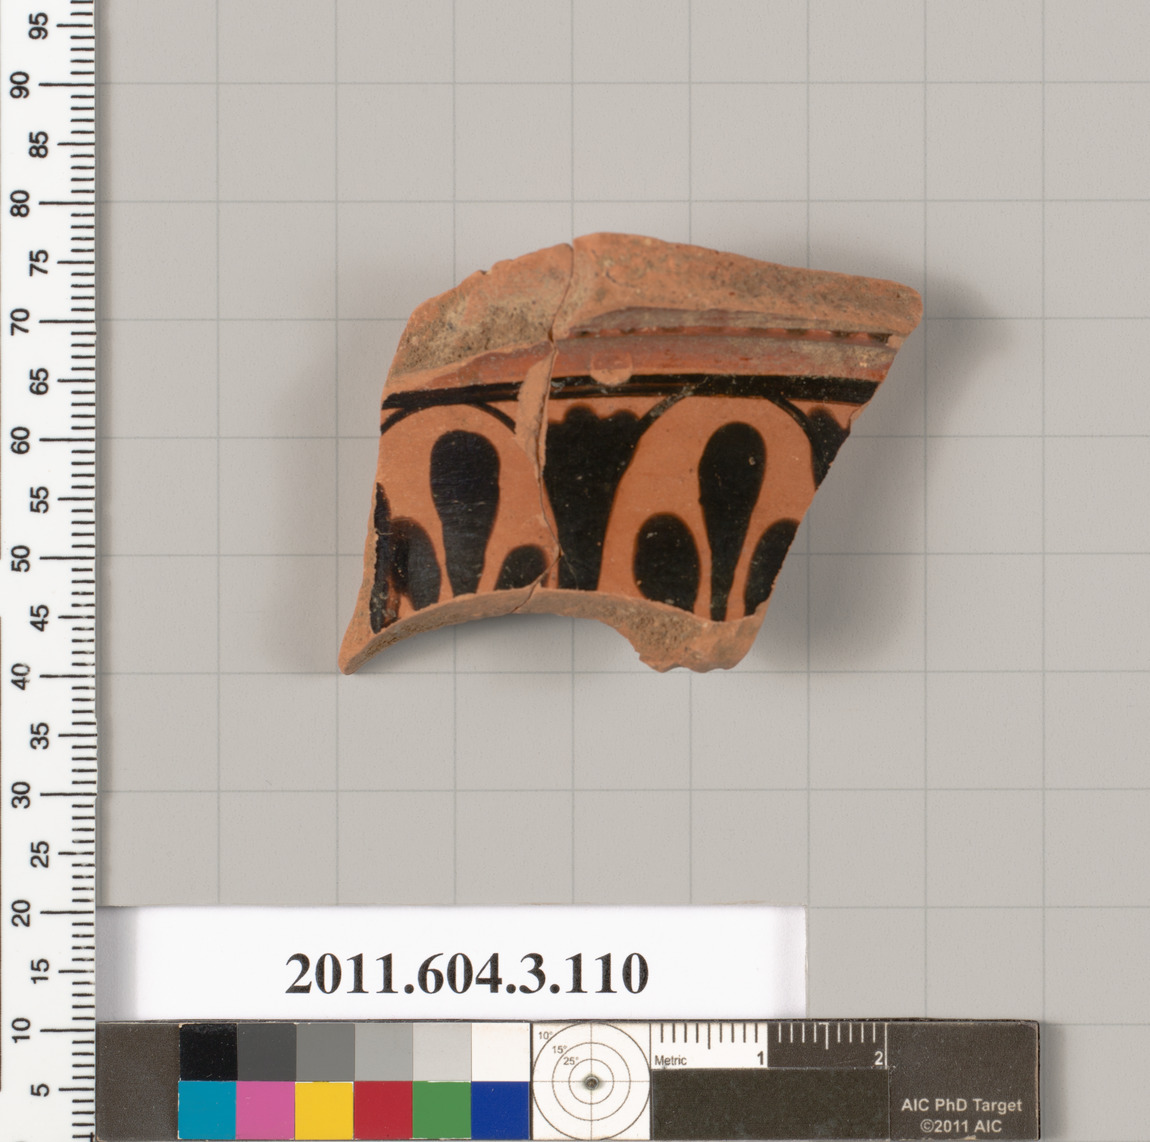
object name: amphora fragment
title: Terracotta fragment of an amphora (jar)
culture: greek, attic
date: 510-500 BCE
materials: terracotta